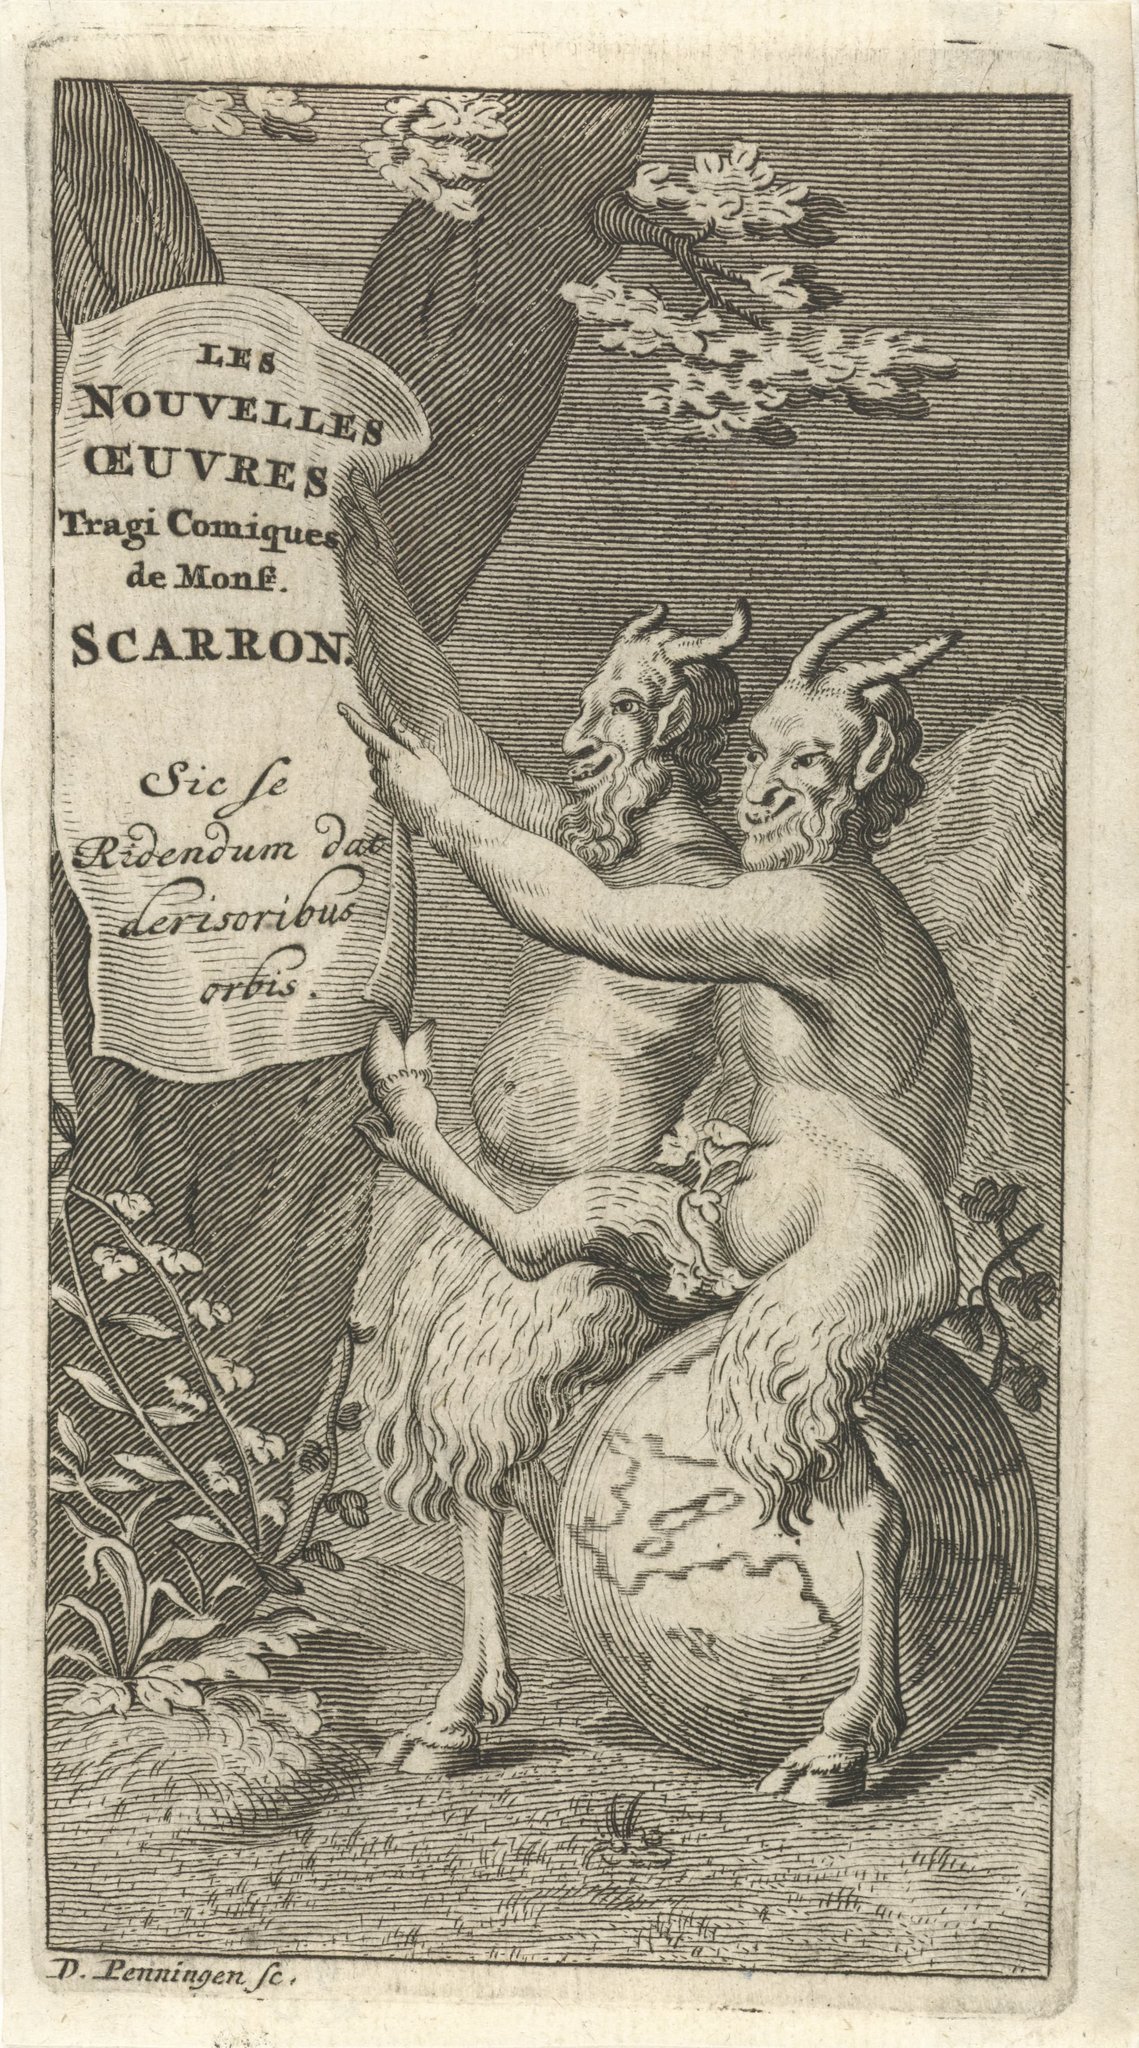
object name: titelblad, titelpagina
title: Titelpagina voor: A. Scarron, Les nouvelles Oeuvres Tragicomiques, 1668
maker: daniël met de penningen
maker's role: print maker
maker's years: -1696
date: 1668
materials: paper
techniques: engraving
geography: amsterdam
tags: satyr(s) (in general), globe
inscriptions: collector's mark: Lugt 2228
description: Landschap met twee saters, van wie één op een globe zit. Ze houden een doek vast waarop de titel in het Latijn.